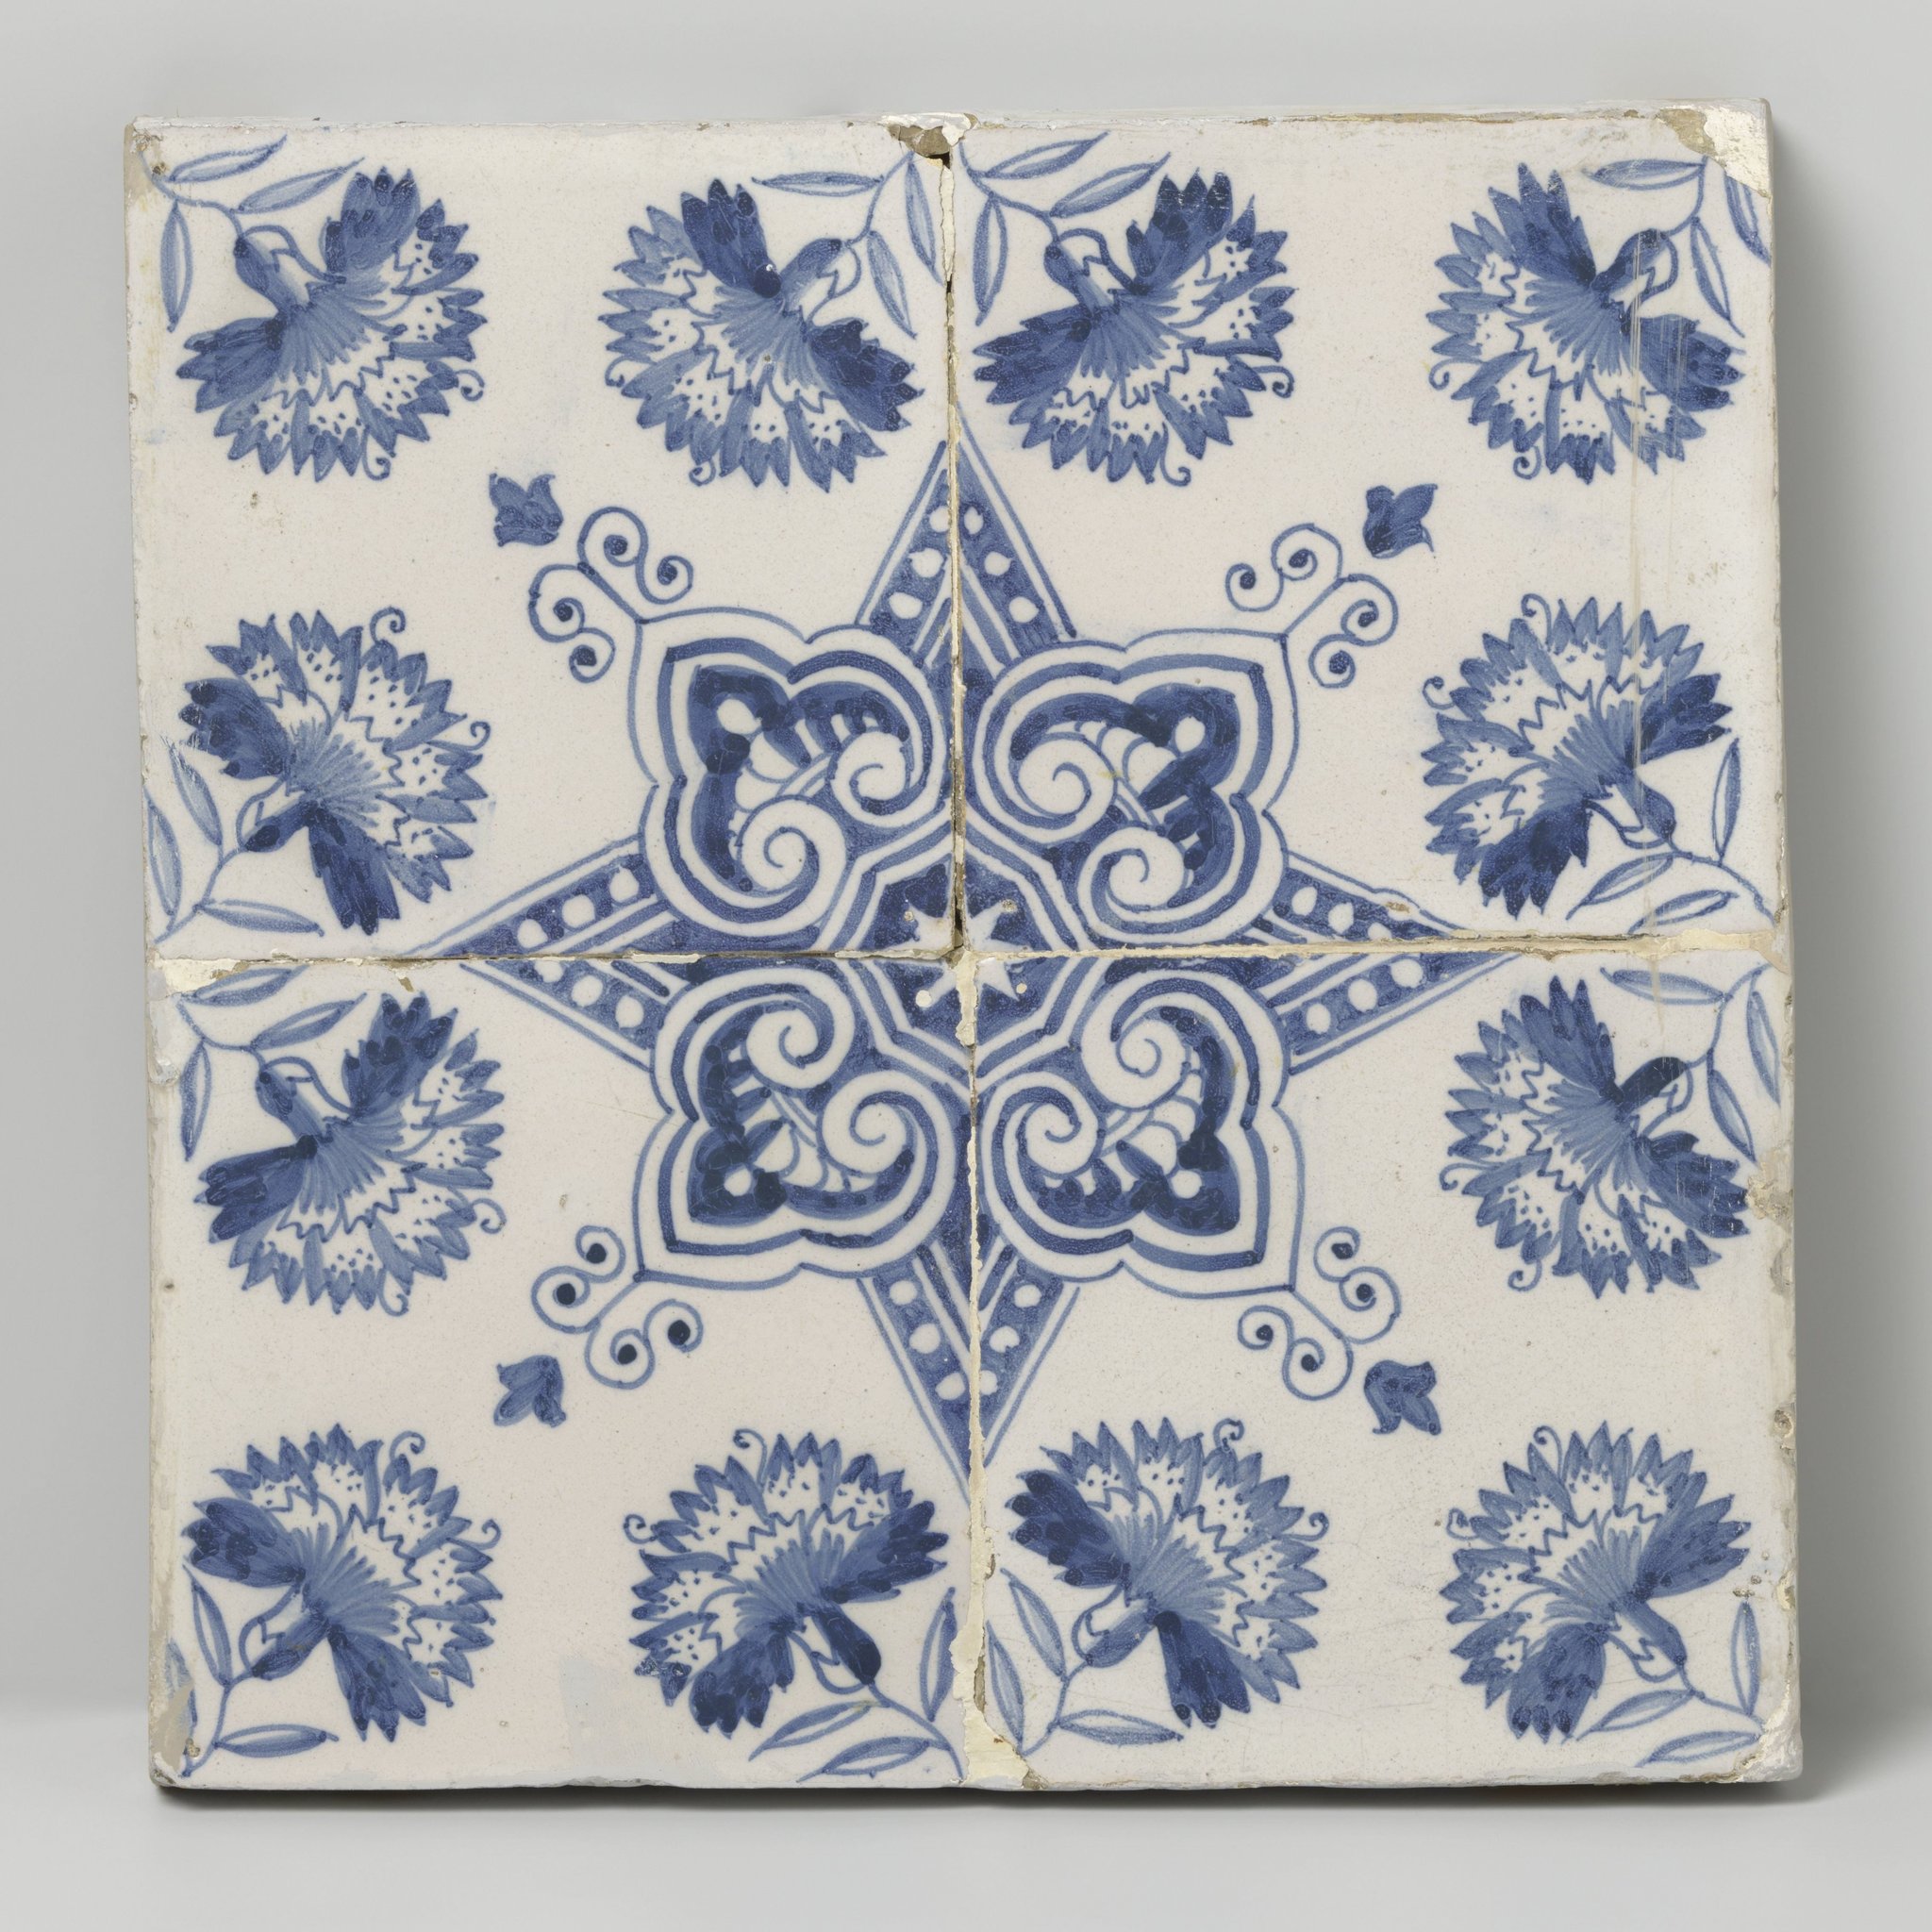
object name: stertegel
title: Veld van vier tegels die samen een ster vormen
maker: Anonymous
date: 1790-1810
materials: earthenware, glaze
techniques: maiolica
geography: netherlands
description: Vier tegels (2 x 2) die samen in het midden een vierpuntige ster vormen versierd met jui-motieven. In de drie overgebleven hoeken, een anjer.